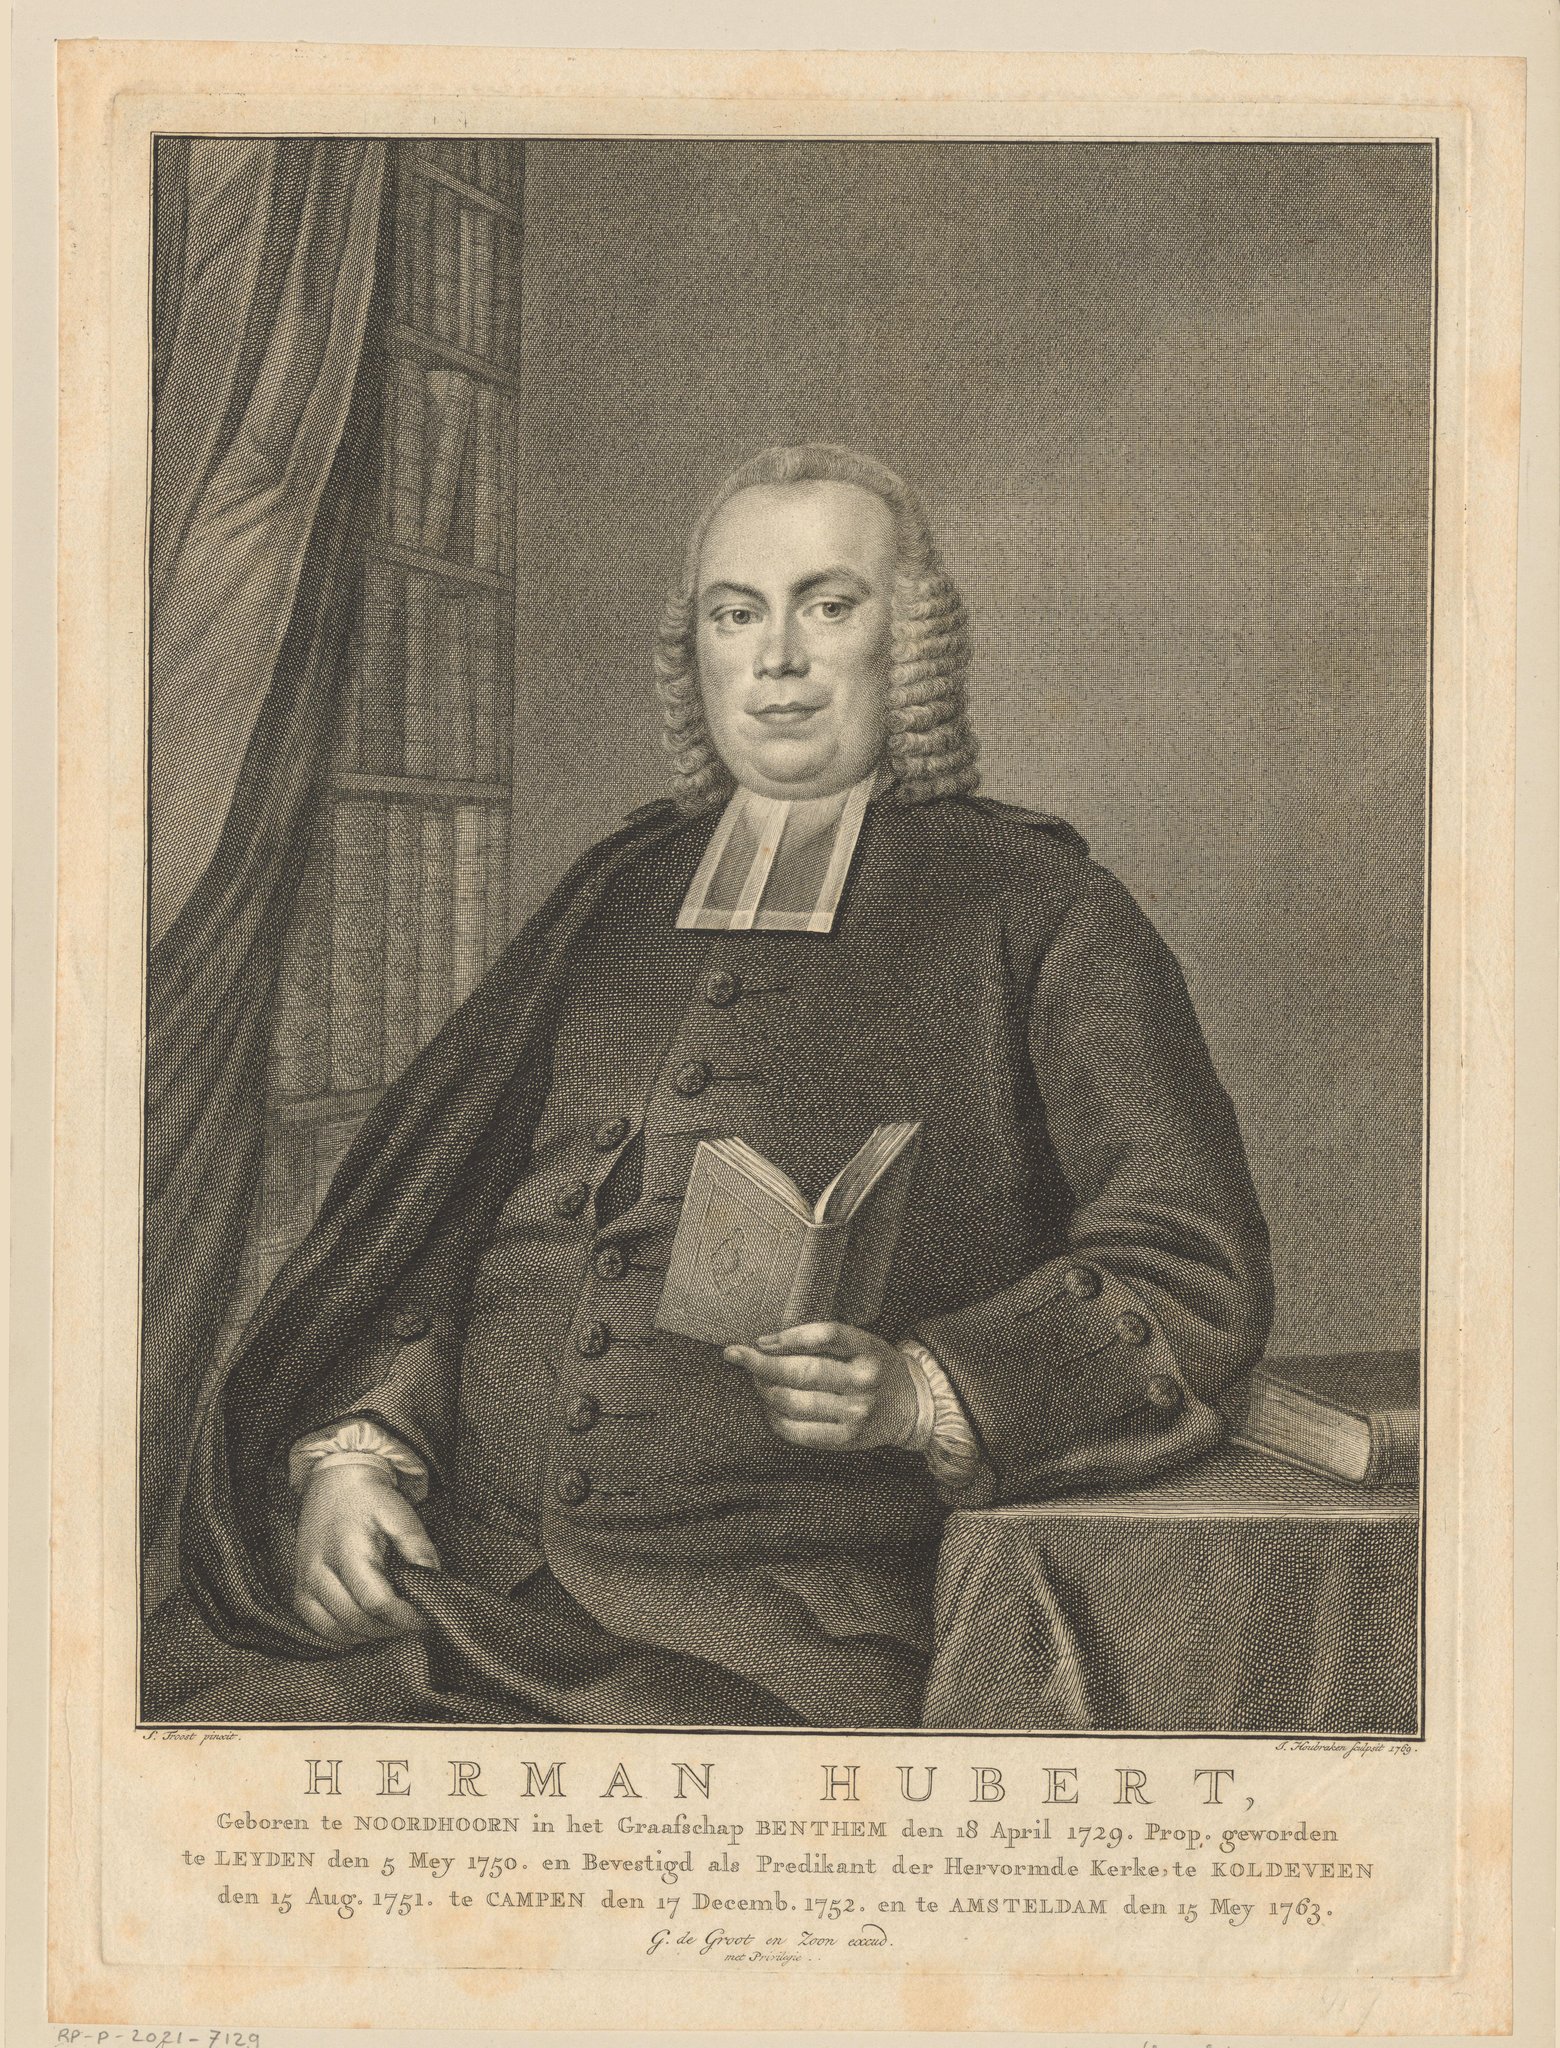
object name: print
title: Portret van Herman Hubert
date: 1769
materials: paper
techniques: engraving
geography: amsterdam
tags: historical persons, functionaries and dignitaries ~ episcopal protestant churches, book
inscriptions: date